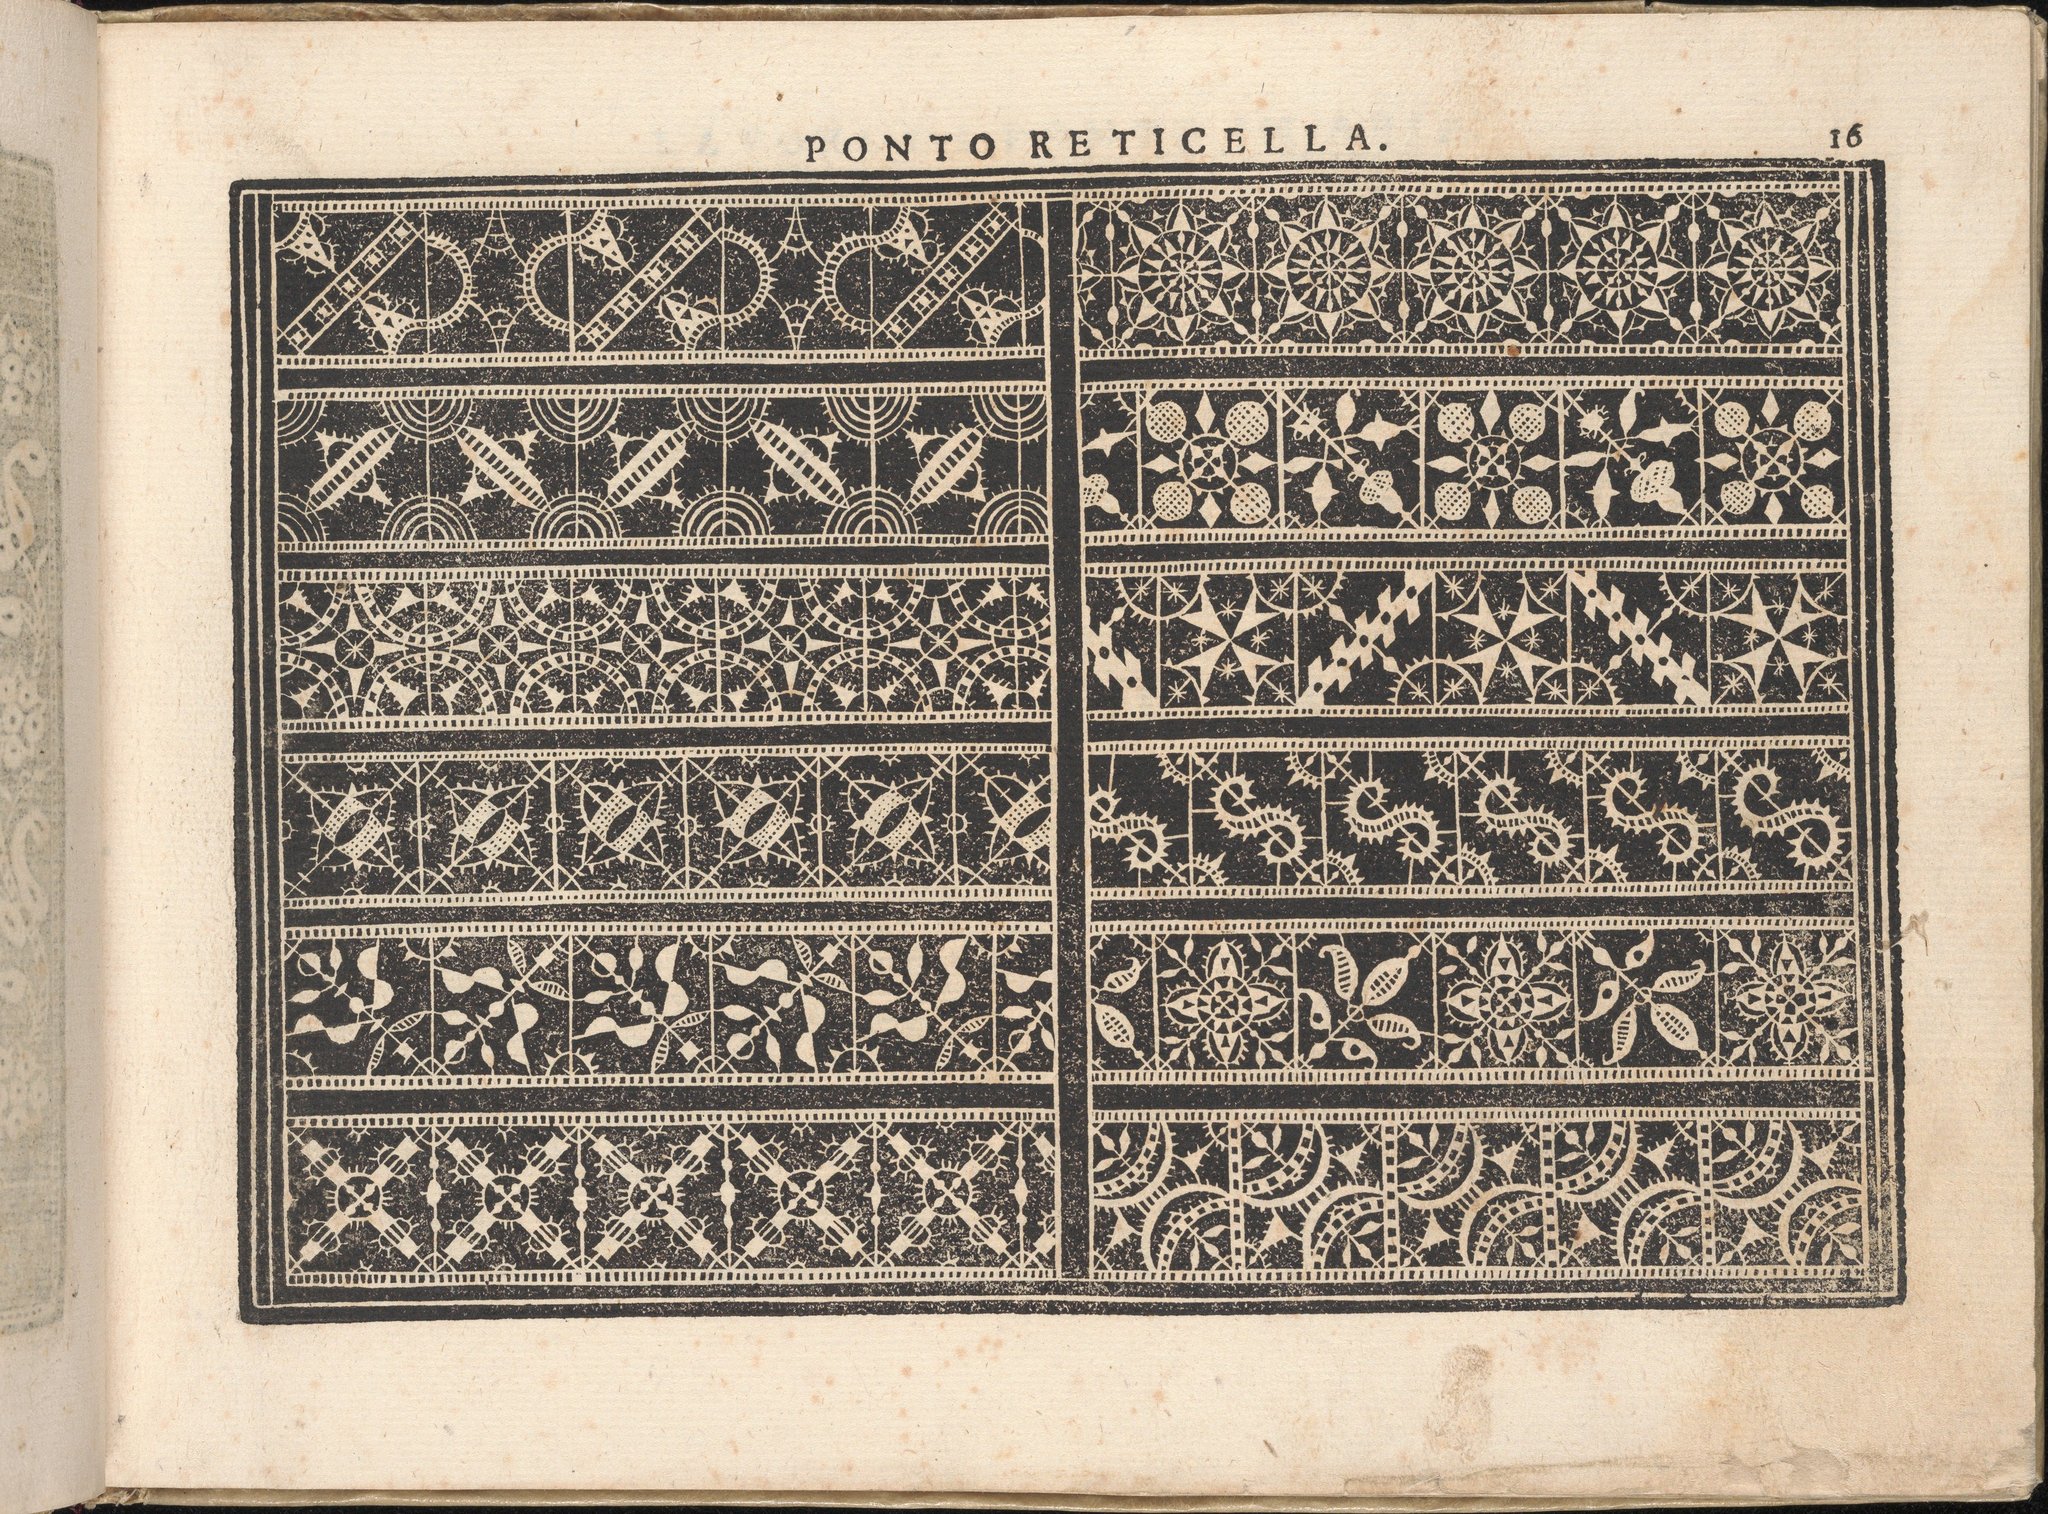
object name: book print ornament architecture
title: Fiore D'Ogni Virtu Per le Nobili Et Honeste Matrone, page 16 (recto)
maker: isabella catanea parasole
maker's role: designer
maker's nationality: italian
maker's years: 1565-1625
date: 1610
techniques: woodcut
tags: flowers